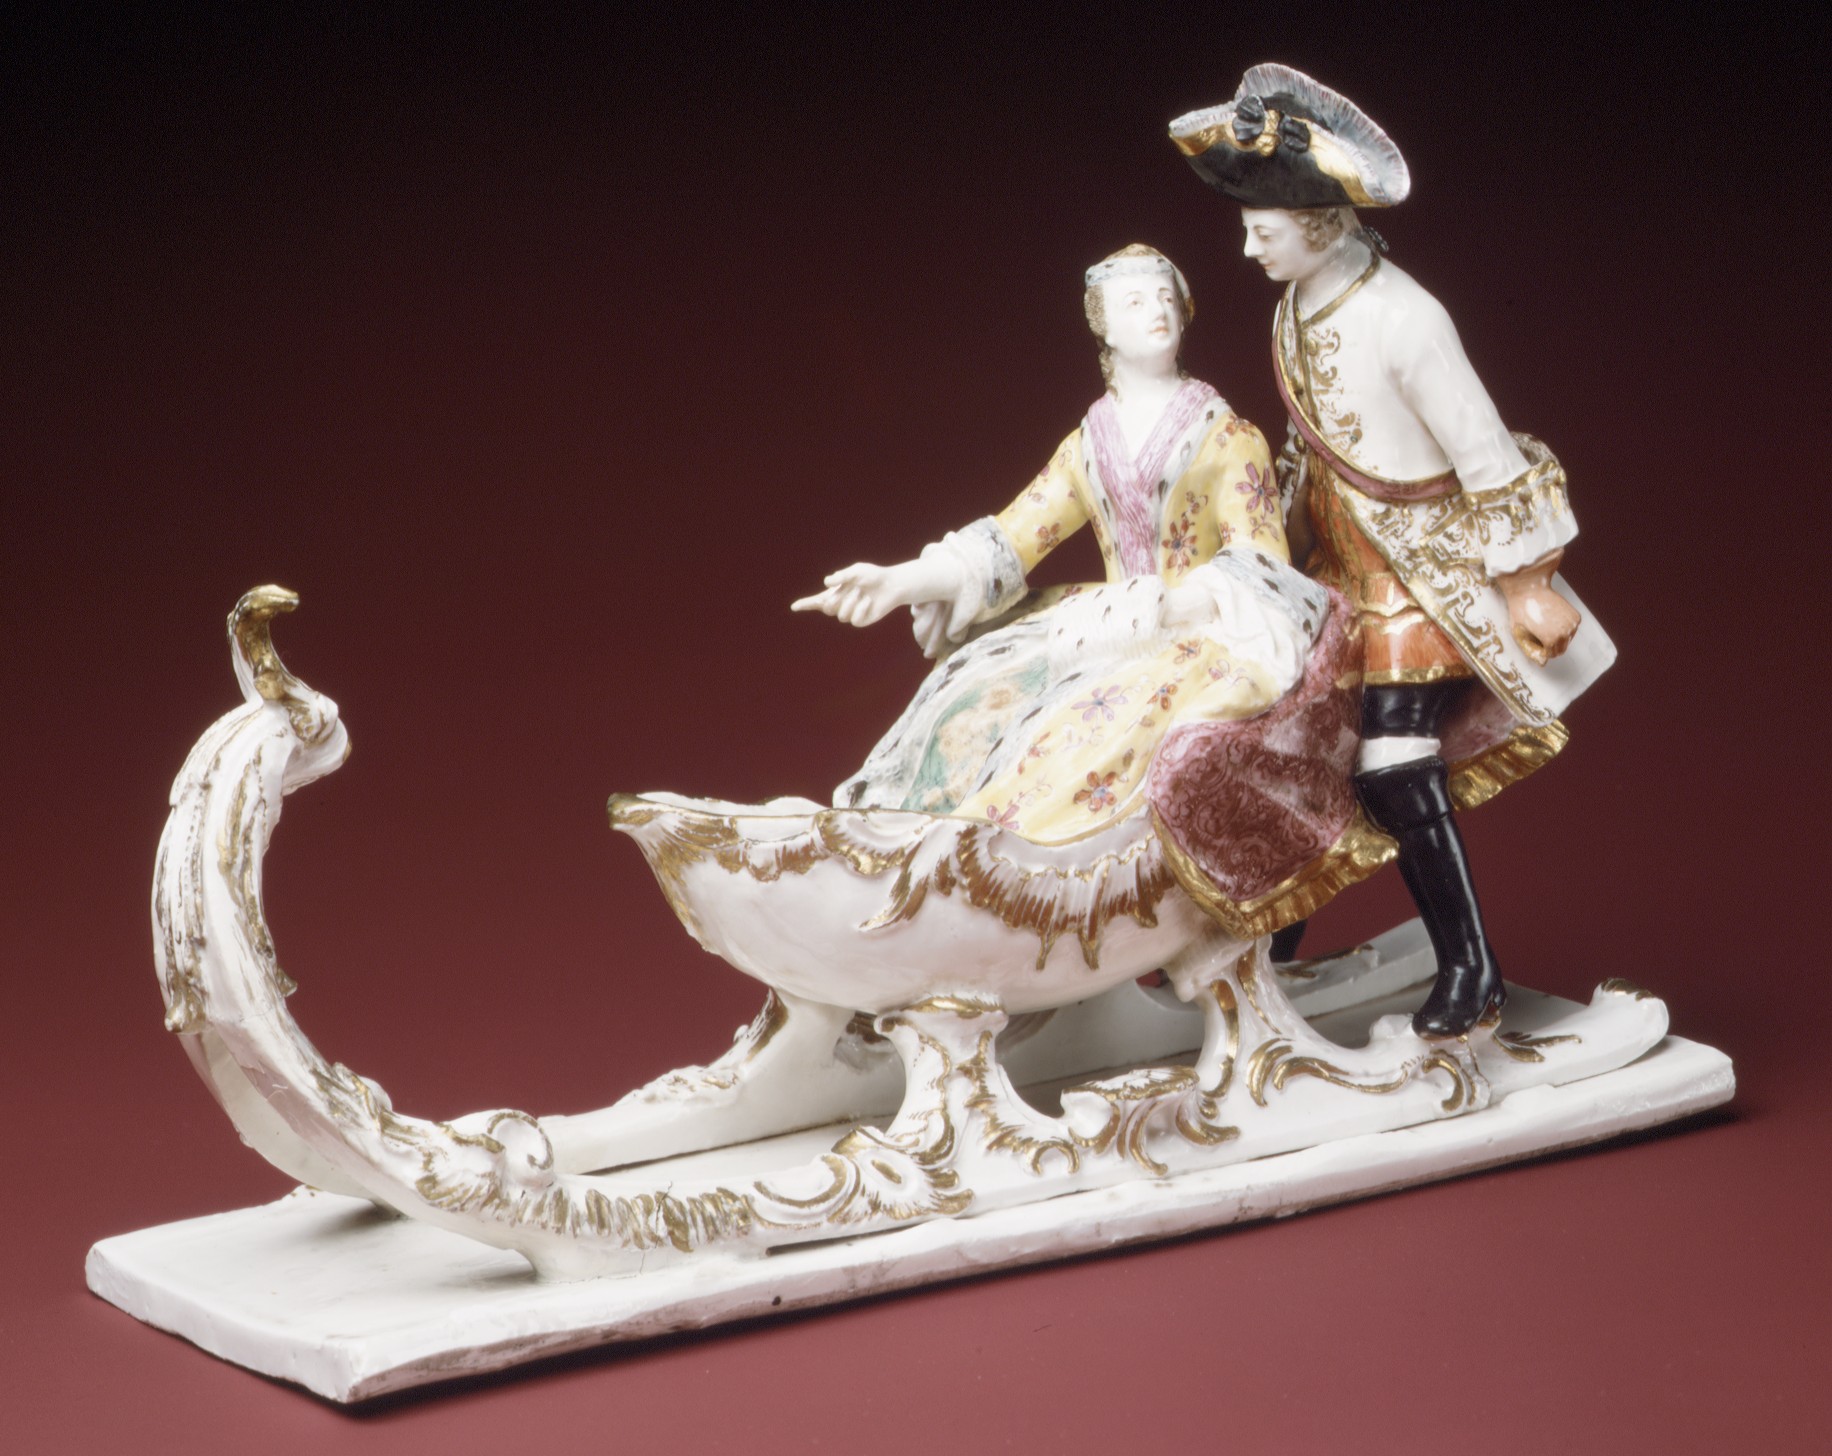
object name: group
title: Man and woman with sleigh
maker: ansbach pottery and porcelain manufactory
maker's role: manufactory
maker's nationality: german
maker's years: 1758-1860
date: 1765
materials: hard paste porcelain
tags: men,women